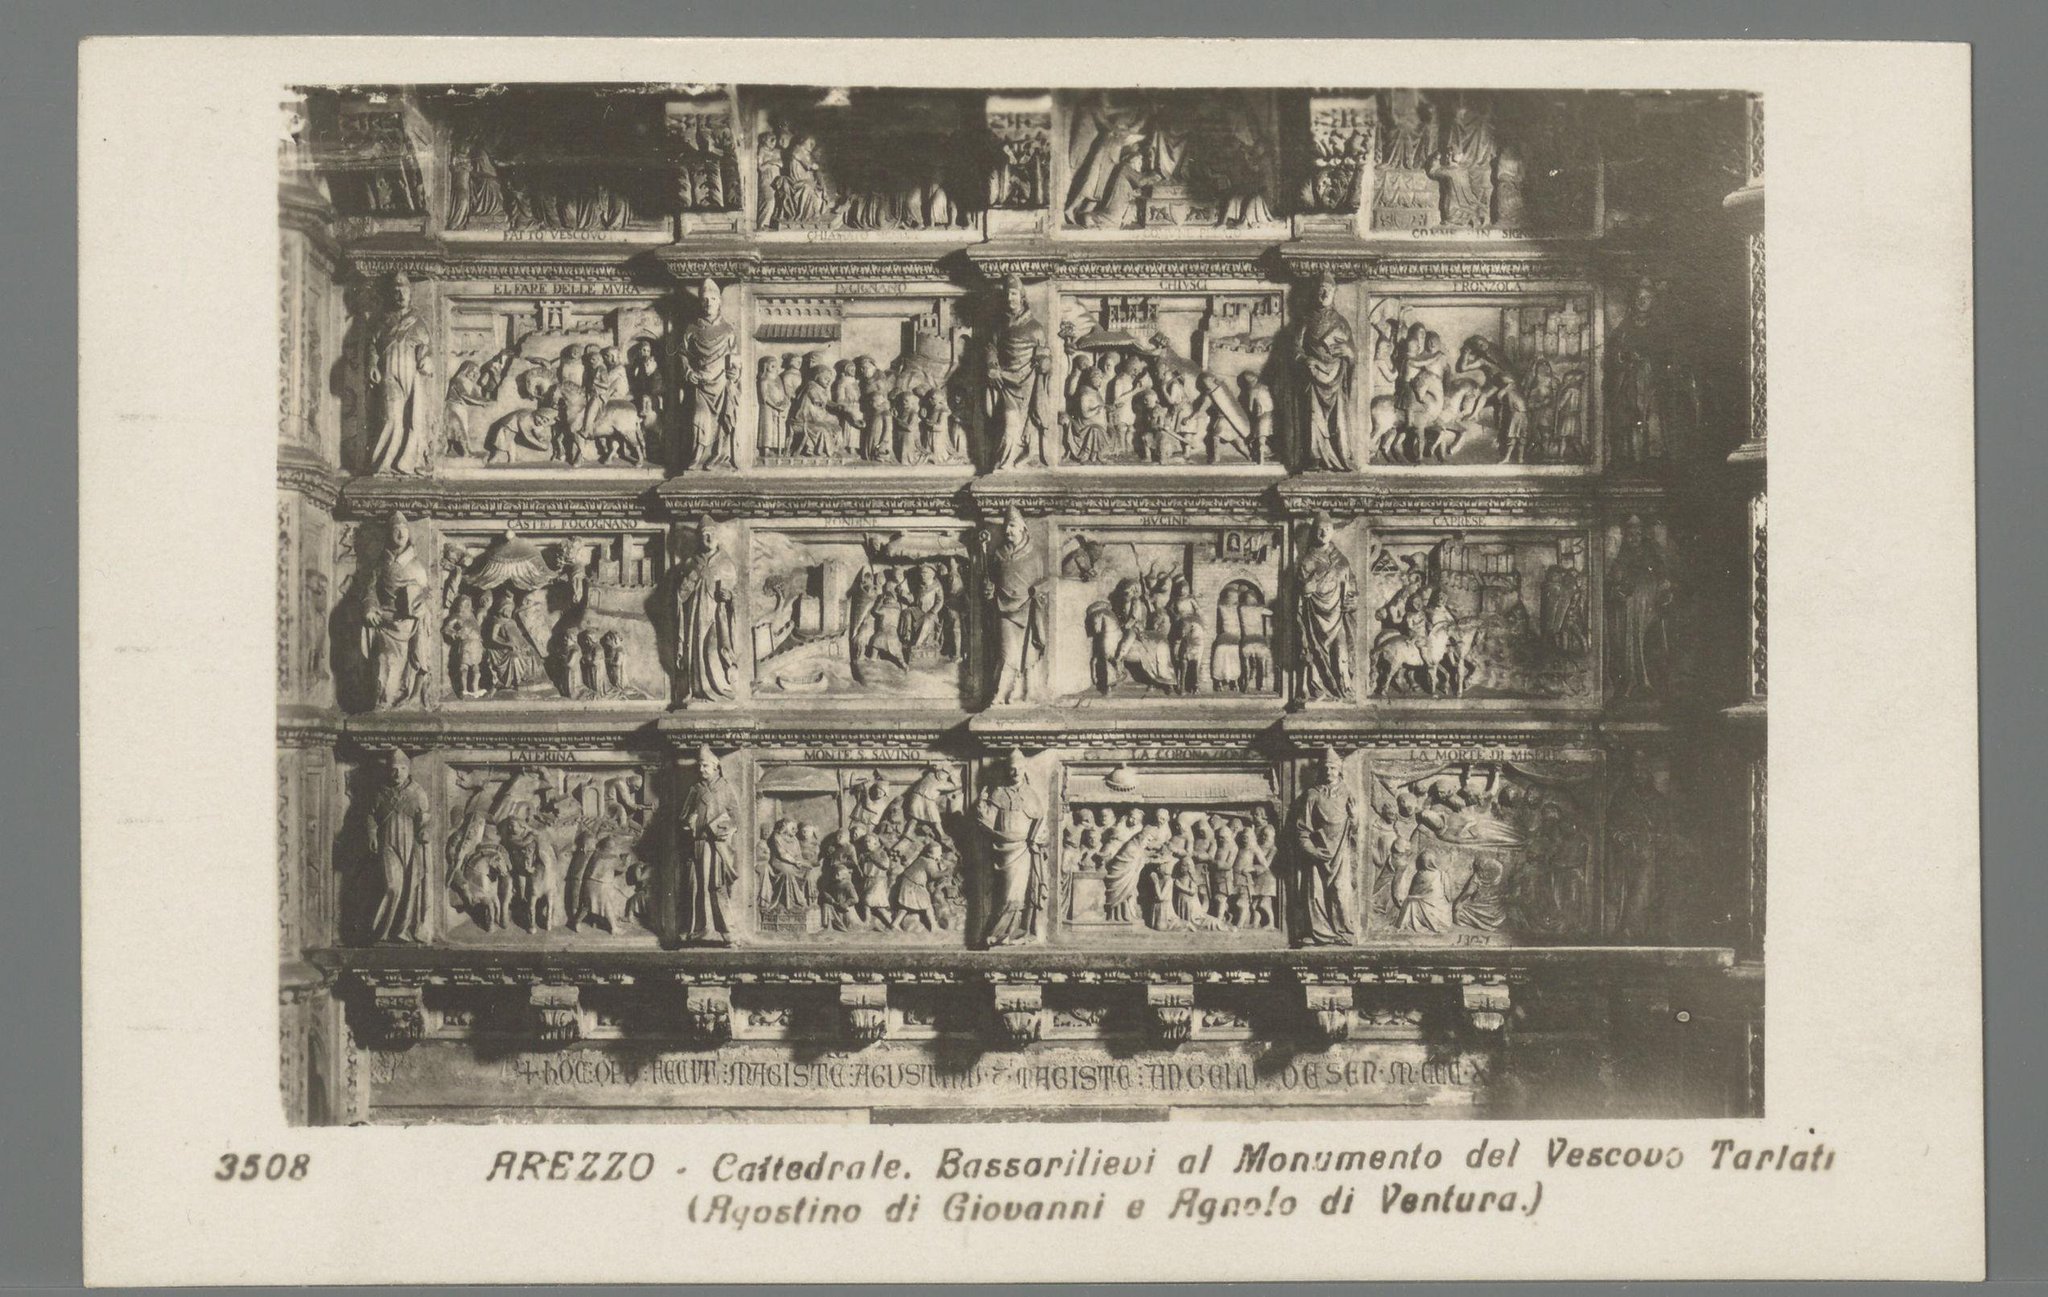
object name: ansichtkaart, prentbriefkaart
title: Arezzo - Cattedrale. Bassorilievi al Monumento del Vescovo Tarlati. (Agostino di Giovanni e Agnolo di Ventura)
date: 1906-1930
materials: paper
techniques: gelatin silver print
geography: arezzo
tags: church (exterior), statues, paintings, etc. ~ objects of worship in roman religion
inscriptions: collector's mark: ‘AFE v S’